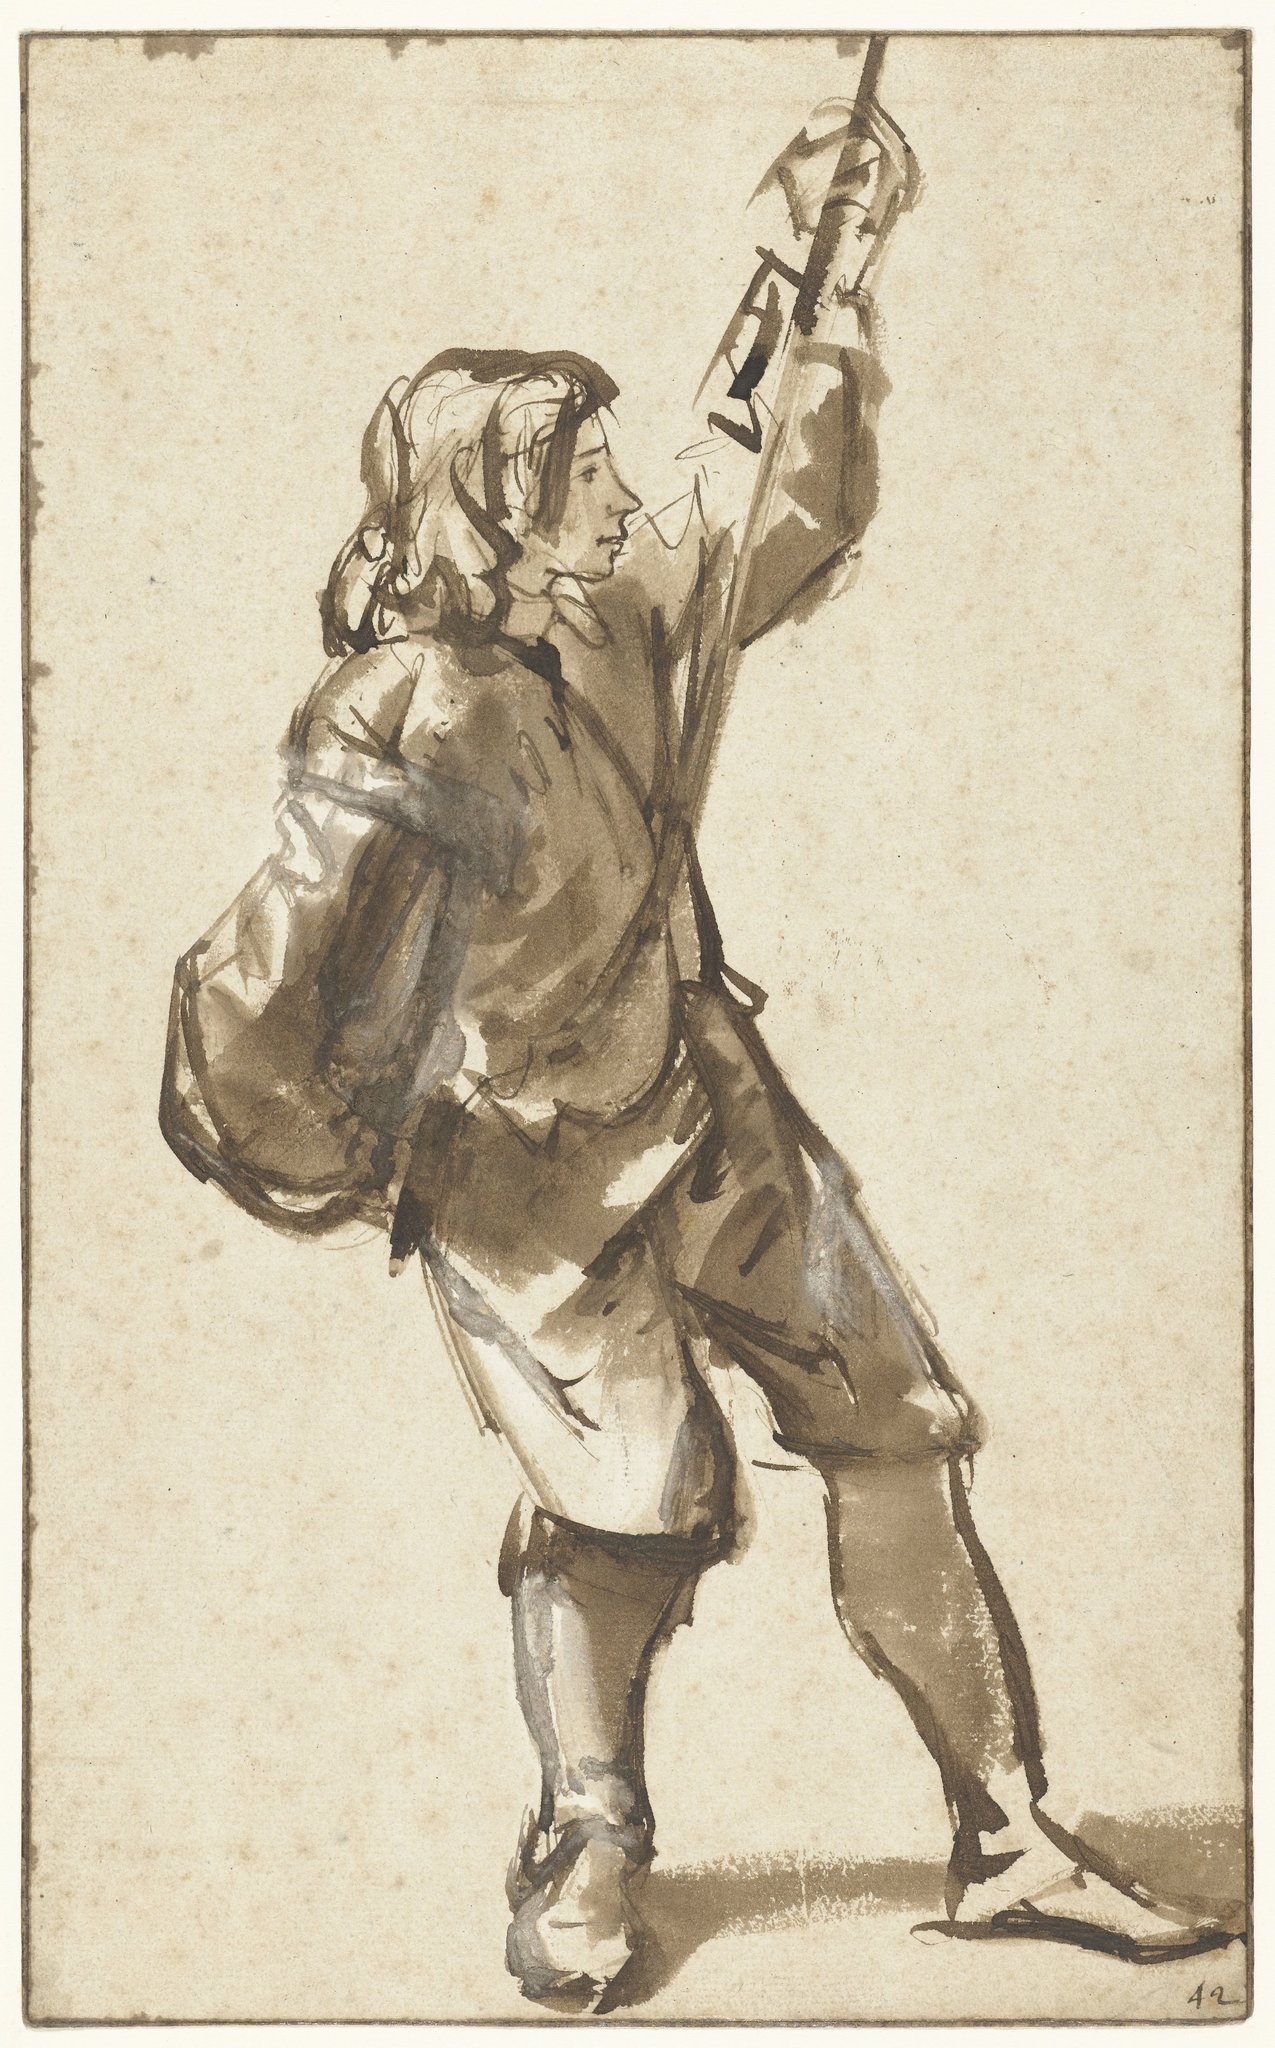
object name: drawing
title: Staande jongen die een touw vasthoudt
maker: carel fabritius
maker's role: draughtsman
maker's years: 1622-1654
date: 1640-1649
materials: ink, paint, paper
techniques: brush, pen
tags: drawing, pulling something, standing figure, tools, aids, implements ~ crafts and industries: rope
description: Marijn Schapelhouman, Rembrandt en de kunst van het tekenen, Zwolle/Amsterdam 2006, p. 32, kleurafb. 26